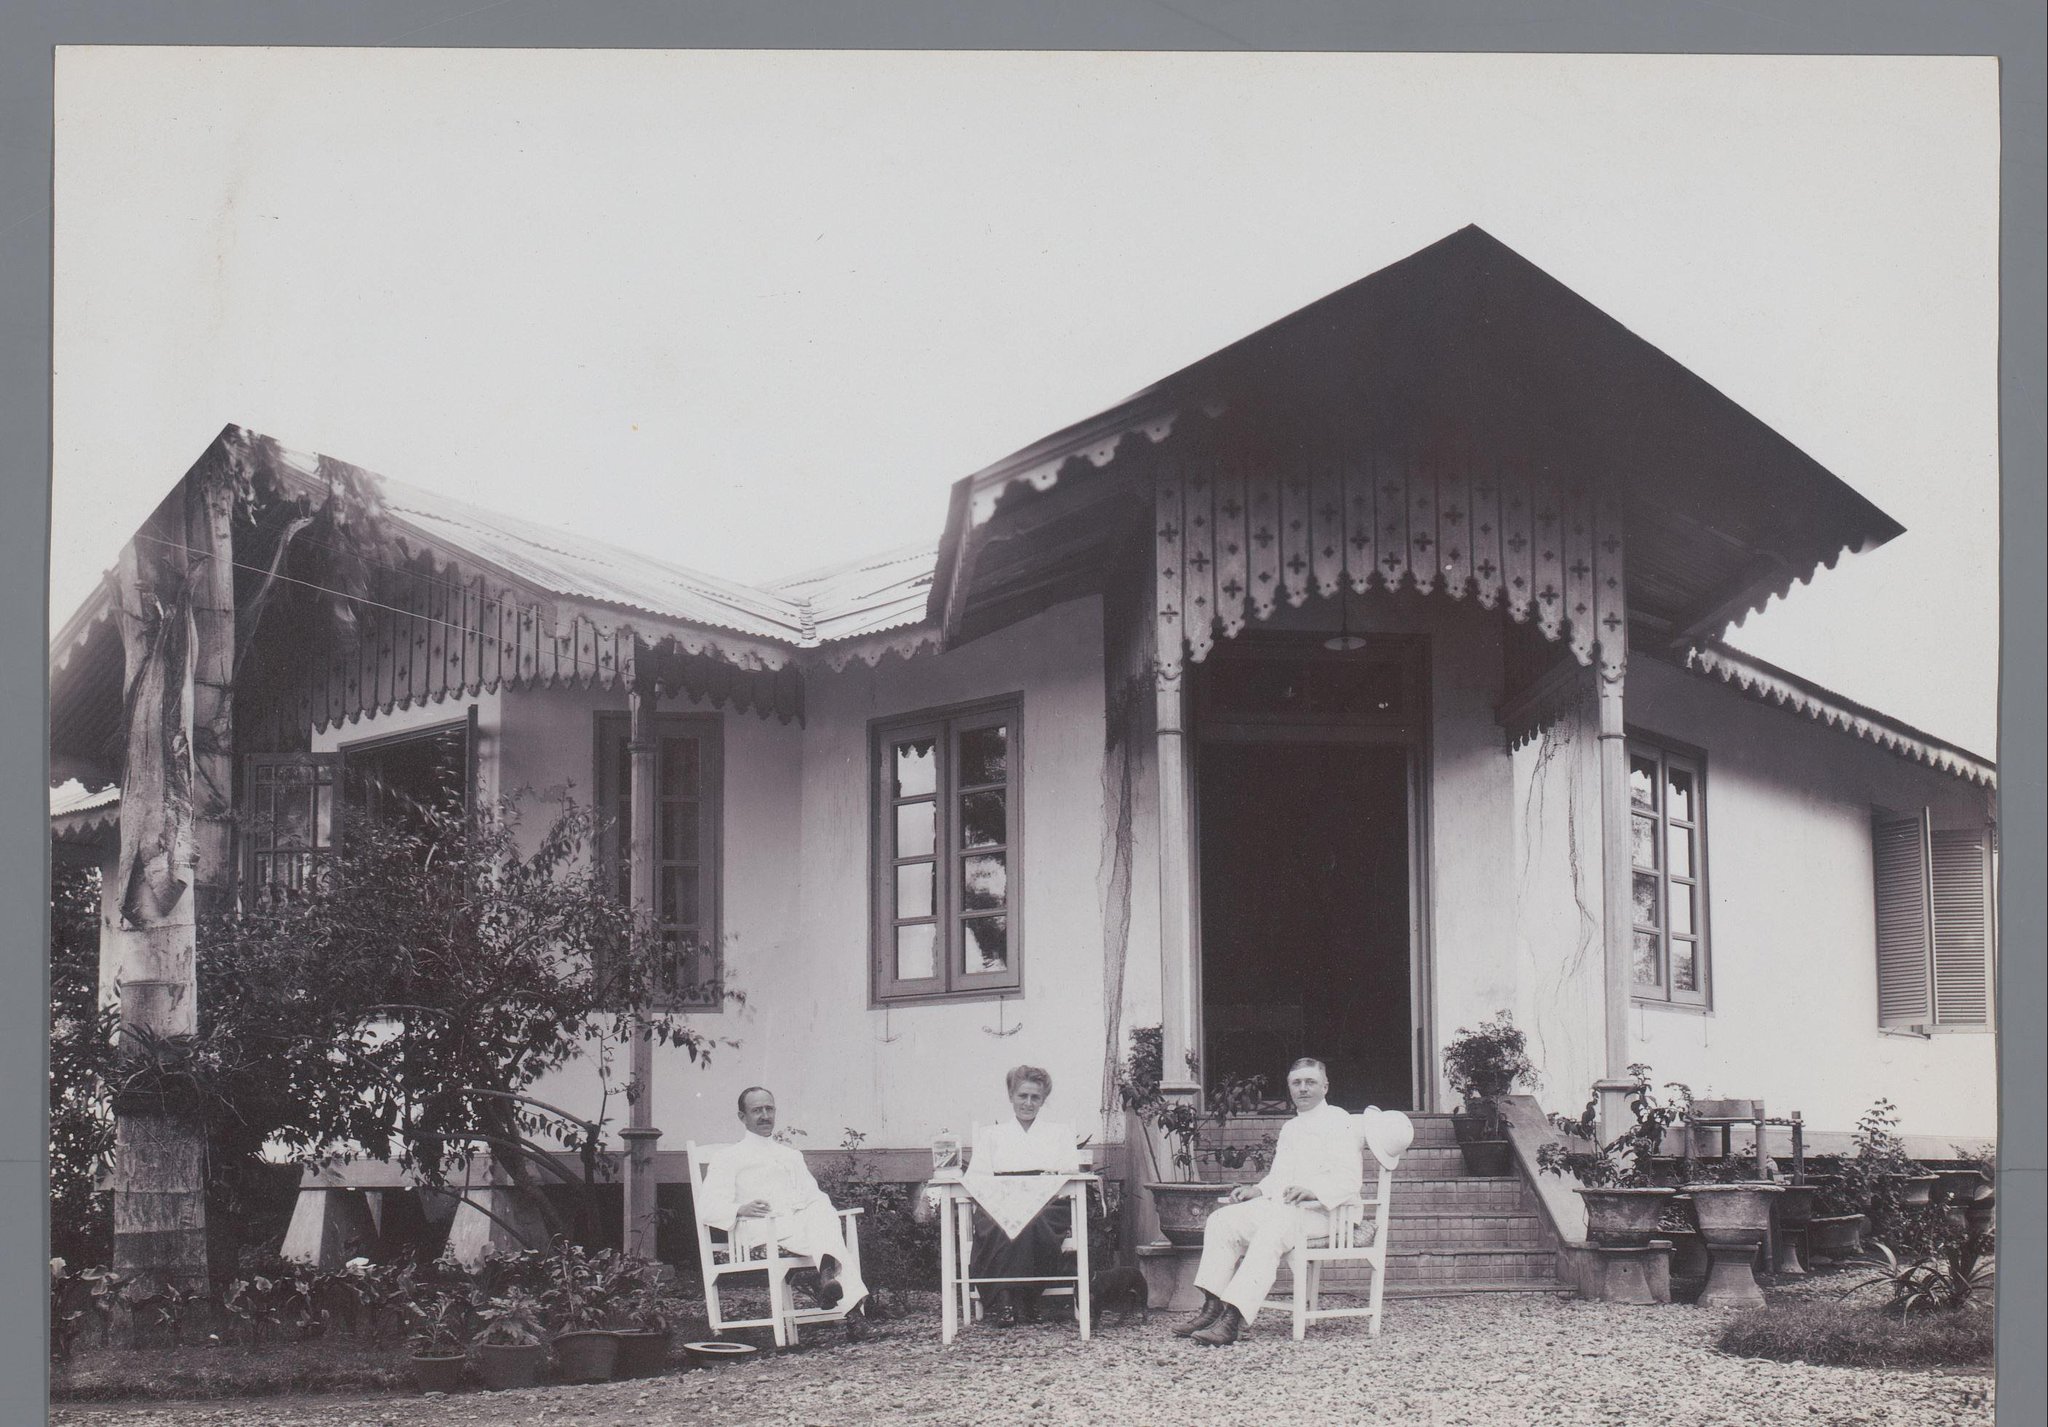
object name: photograph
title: Groot huis in Nederlands-Indië, met een vrouw en twee mannen zittend voor het huis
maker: Anonymous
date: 1900-1920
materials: paper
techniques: albumen print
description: Groot huis in Nederlands-Indië, het huis heeft twee uitbouwen met een afdak. Voor een open deur zitten een vrouw en twee mannen in het wit gekleed, aan een tafel. Aan de stoel van de rechter man hangt een witte tropenhelm. Lijmresten op achterkant foto (ingeplakt in album?].